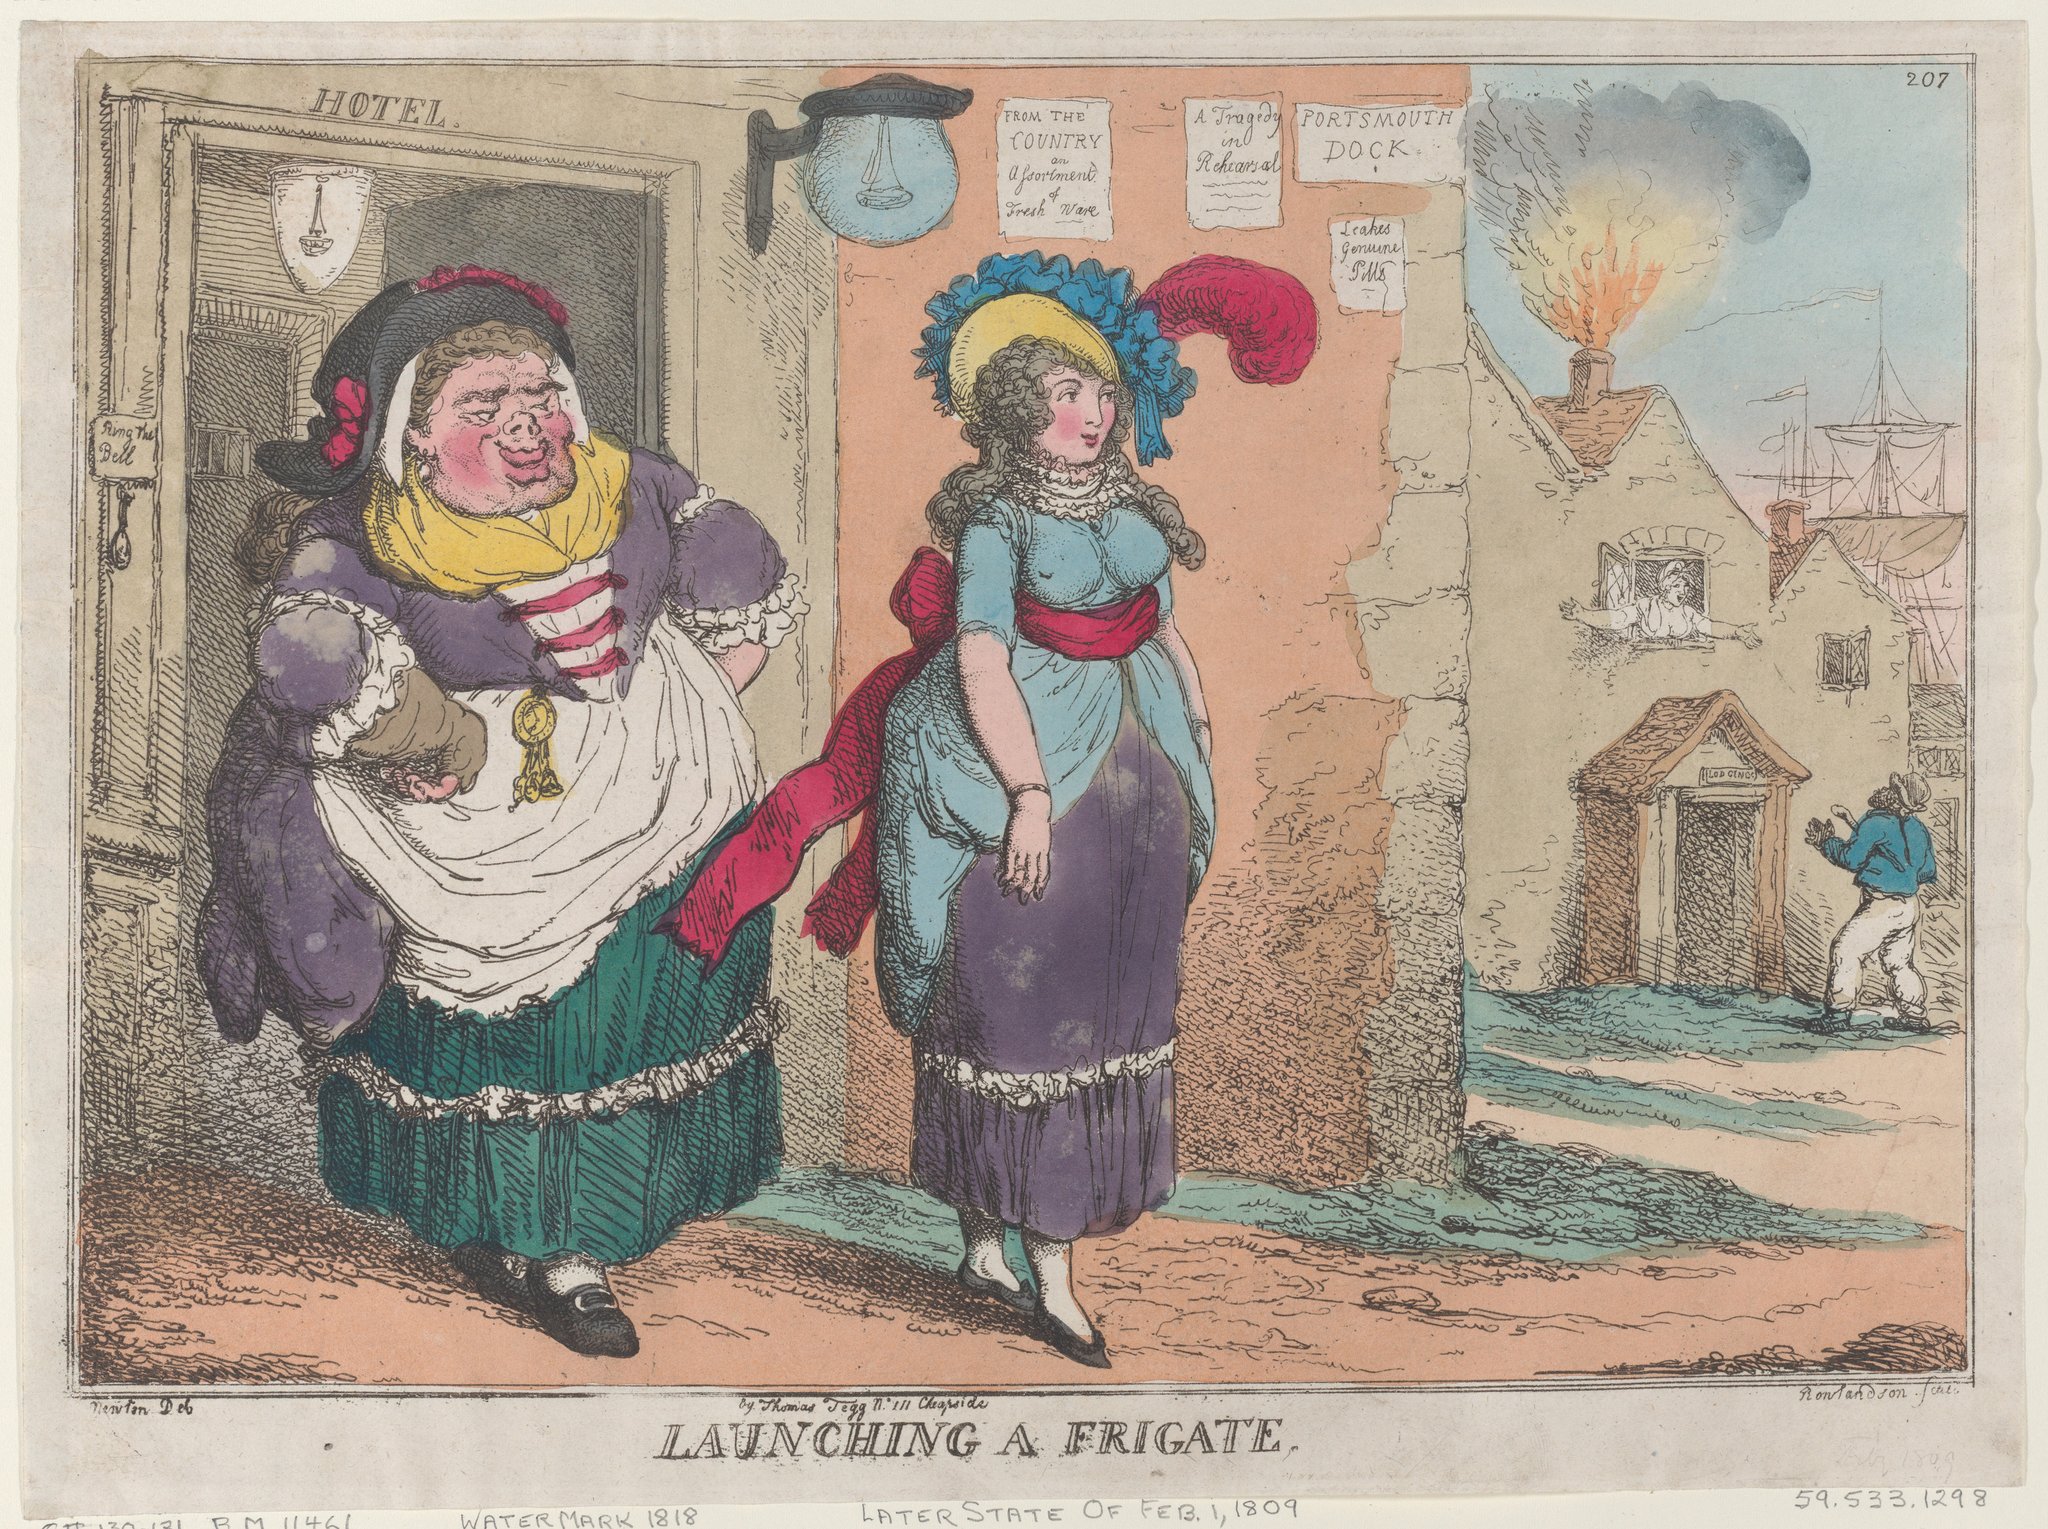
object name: print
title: Launching a Frigate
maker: thomas rowlandson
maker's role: artist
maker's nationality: british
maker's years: 1757-1827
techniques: etching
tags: satire,women,prostitutes